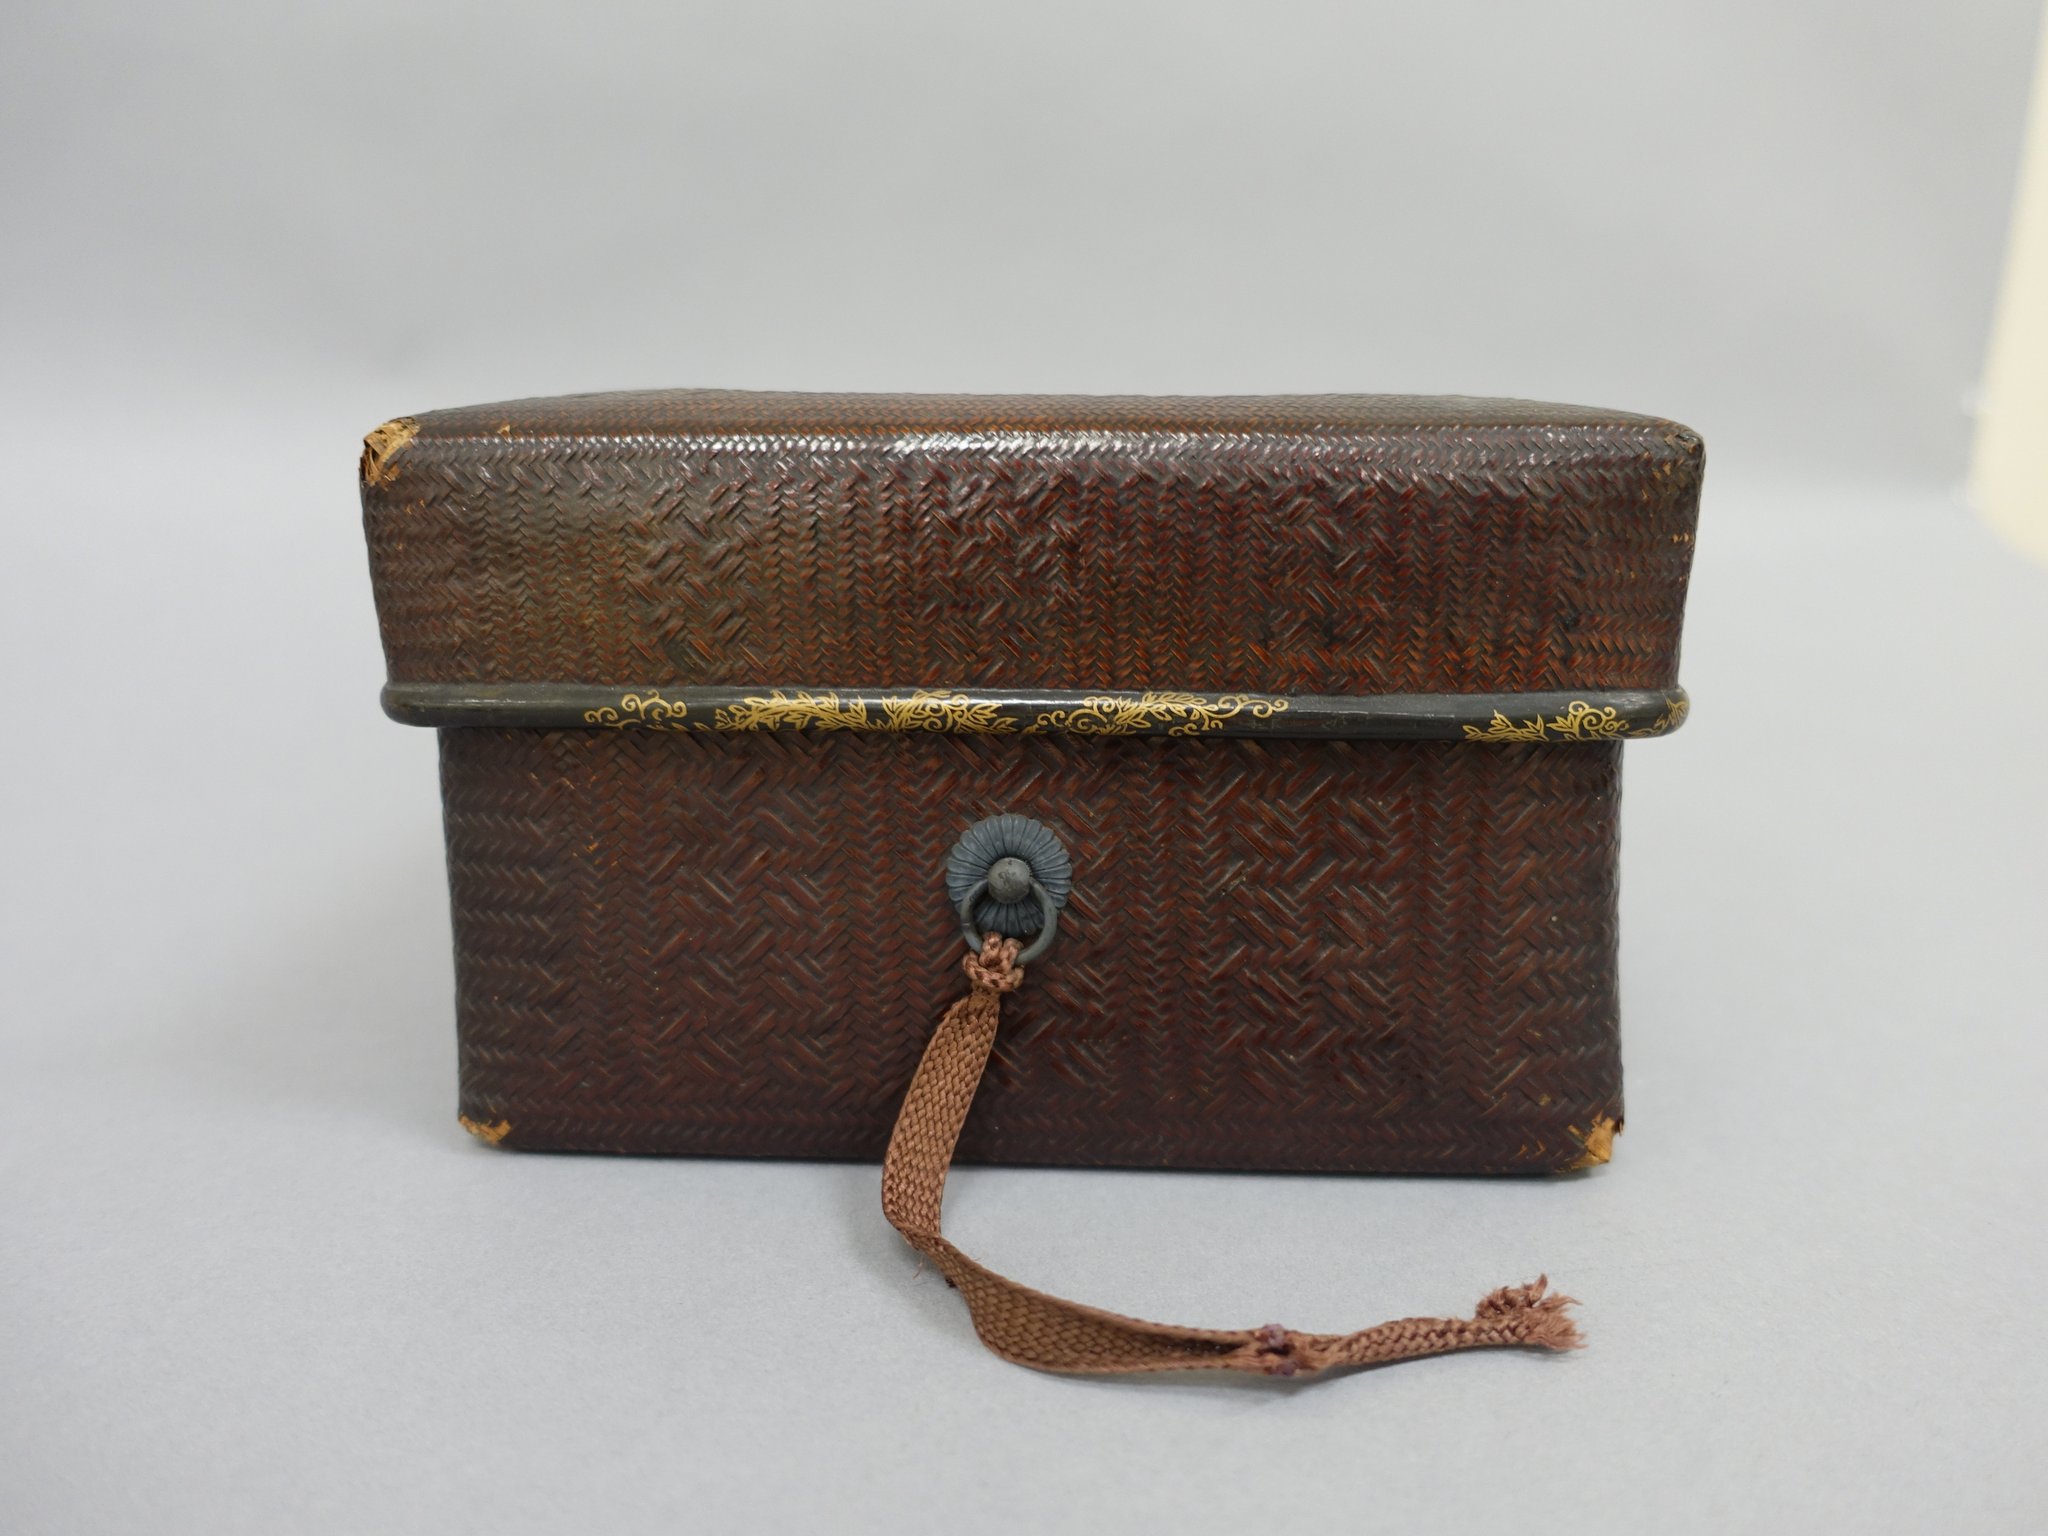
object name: basket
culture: japanese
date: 1801-1900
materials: bamboo